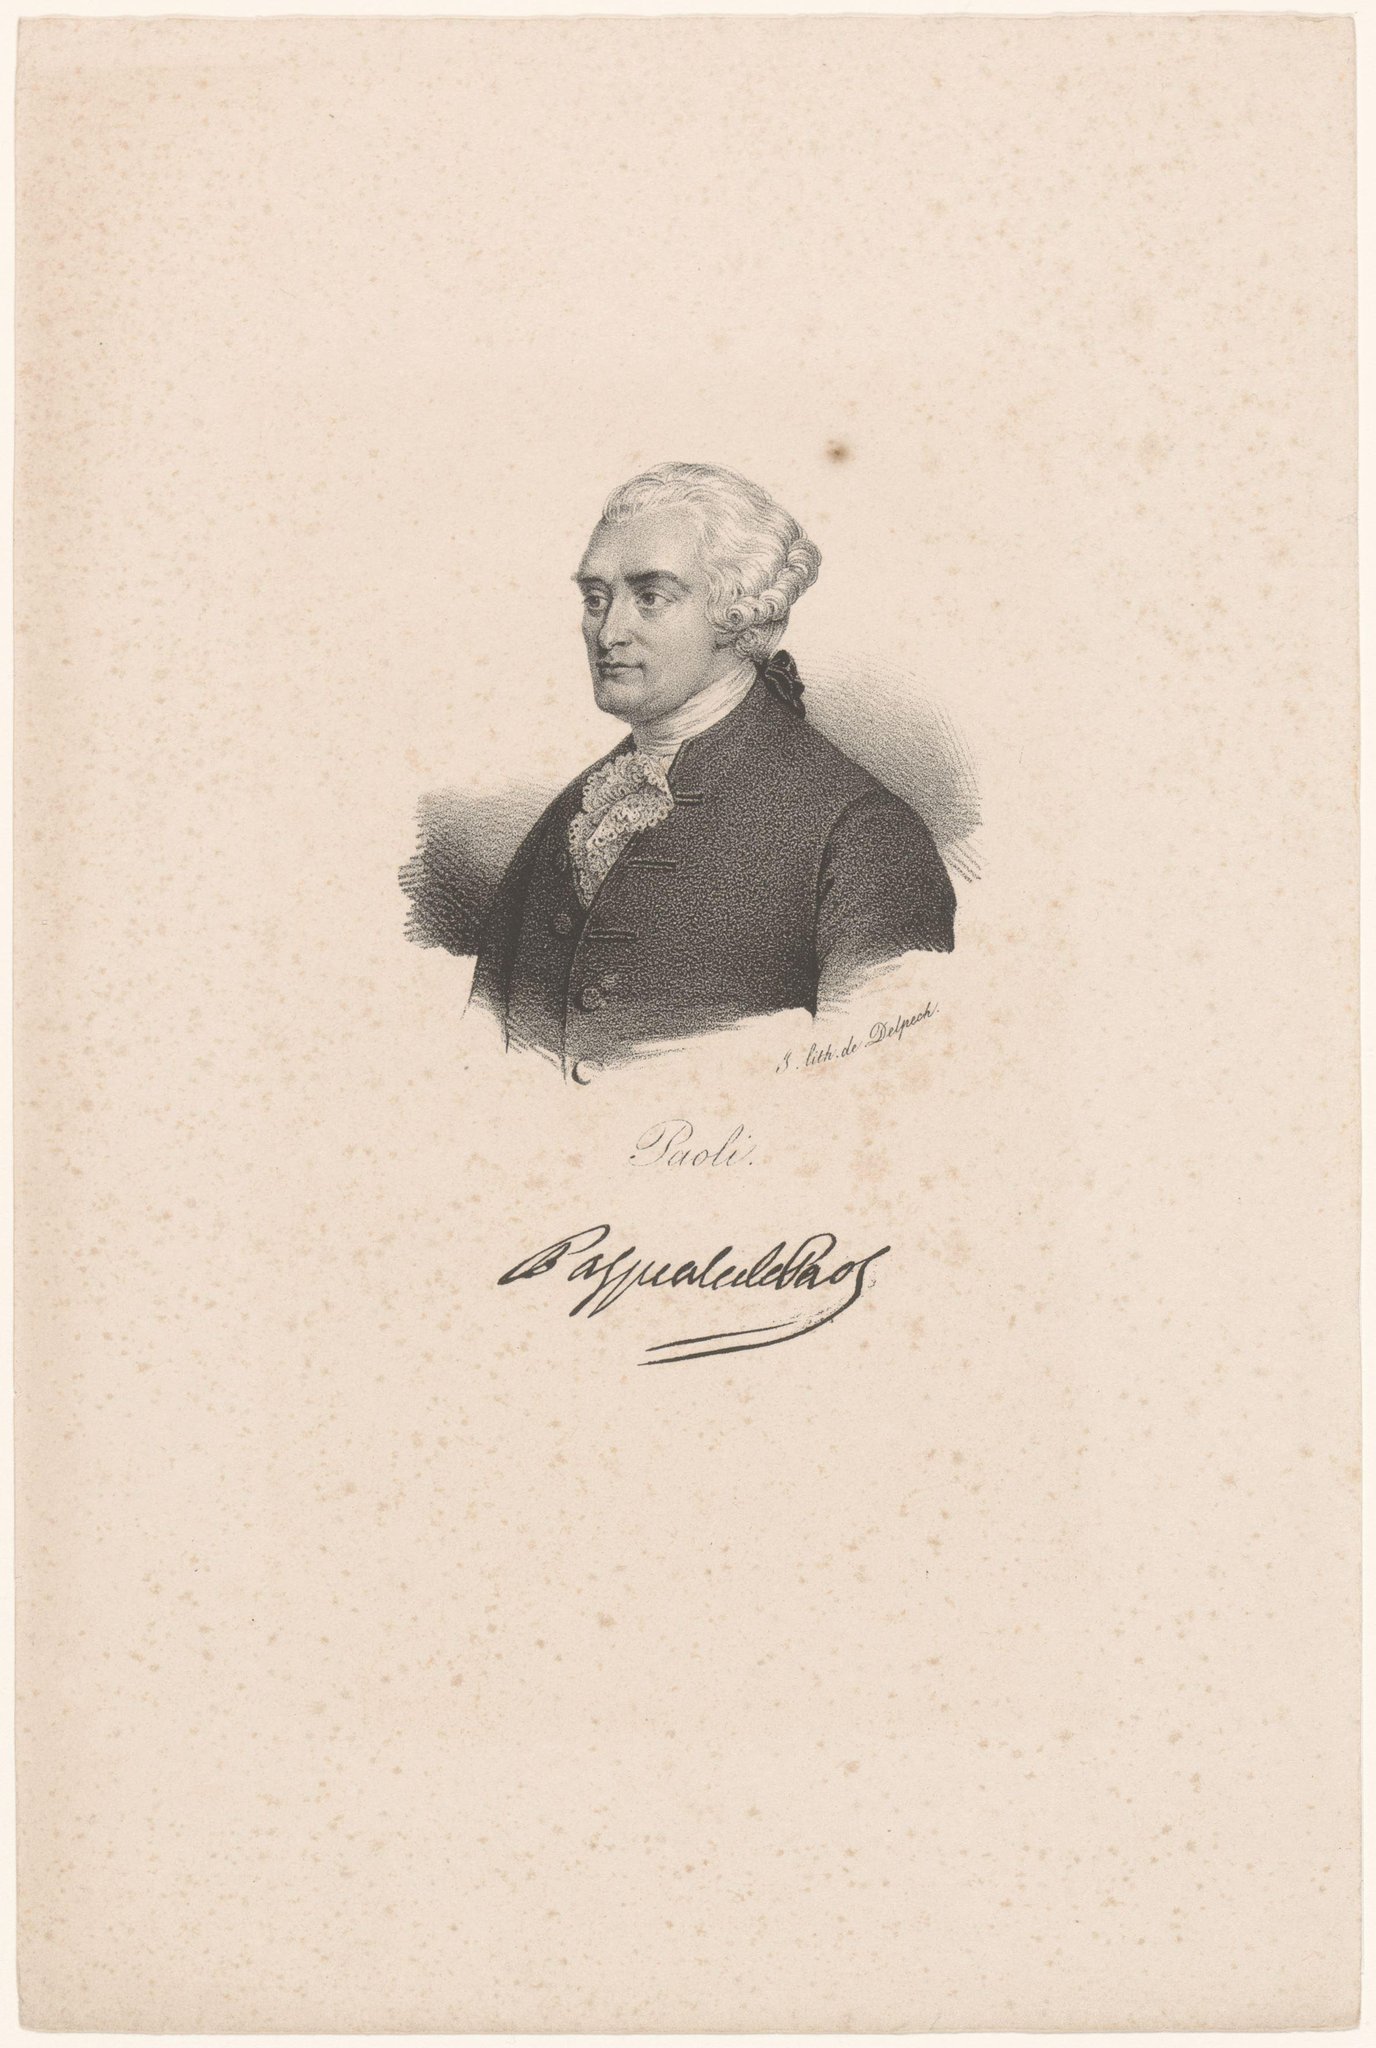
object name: print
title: Paoli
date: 1818-1842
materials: paper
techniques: lithograph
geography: paris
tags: historical persons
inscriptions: collector's mark: Lugt 2228a